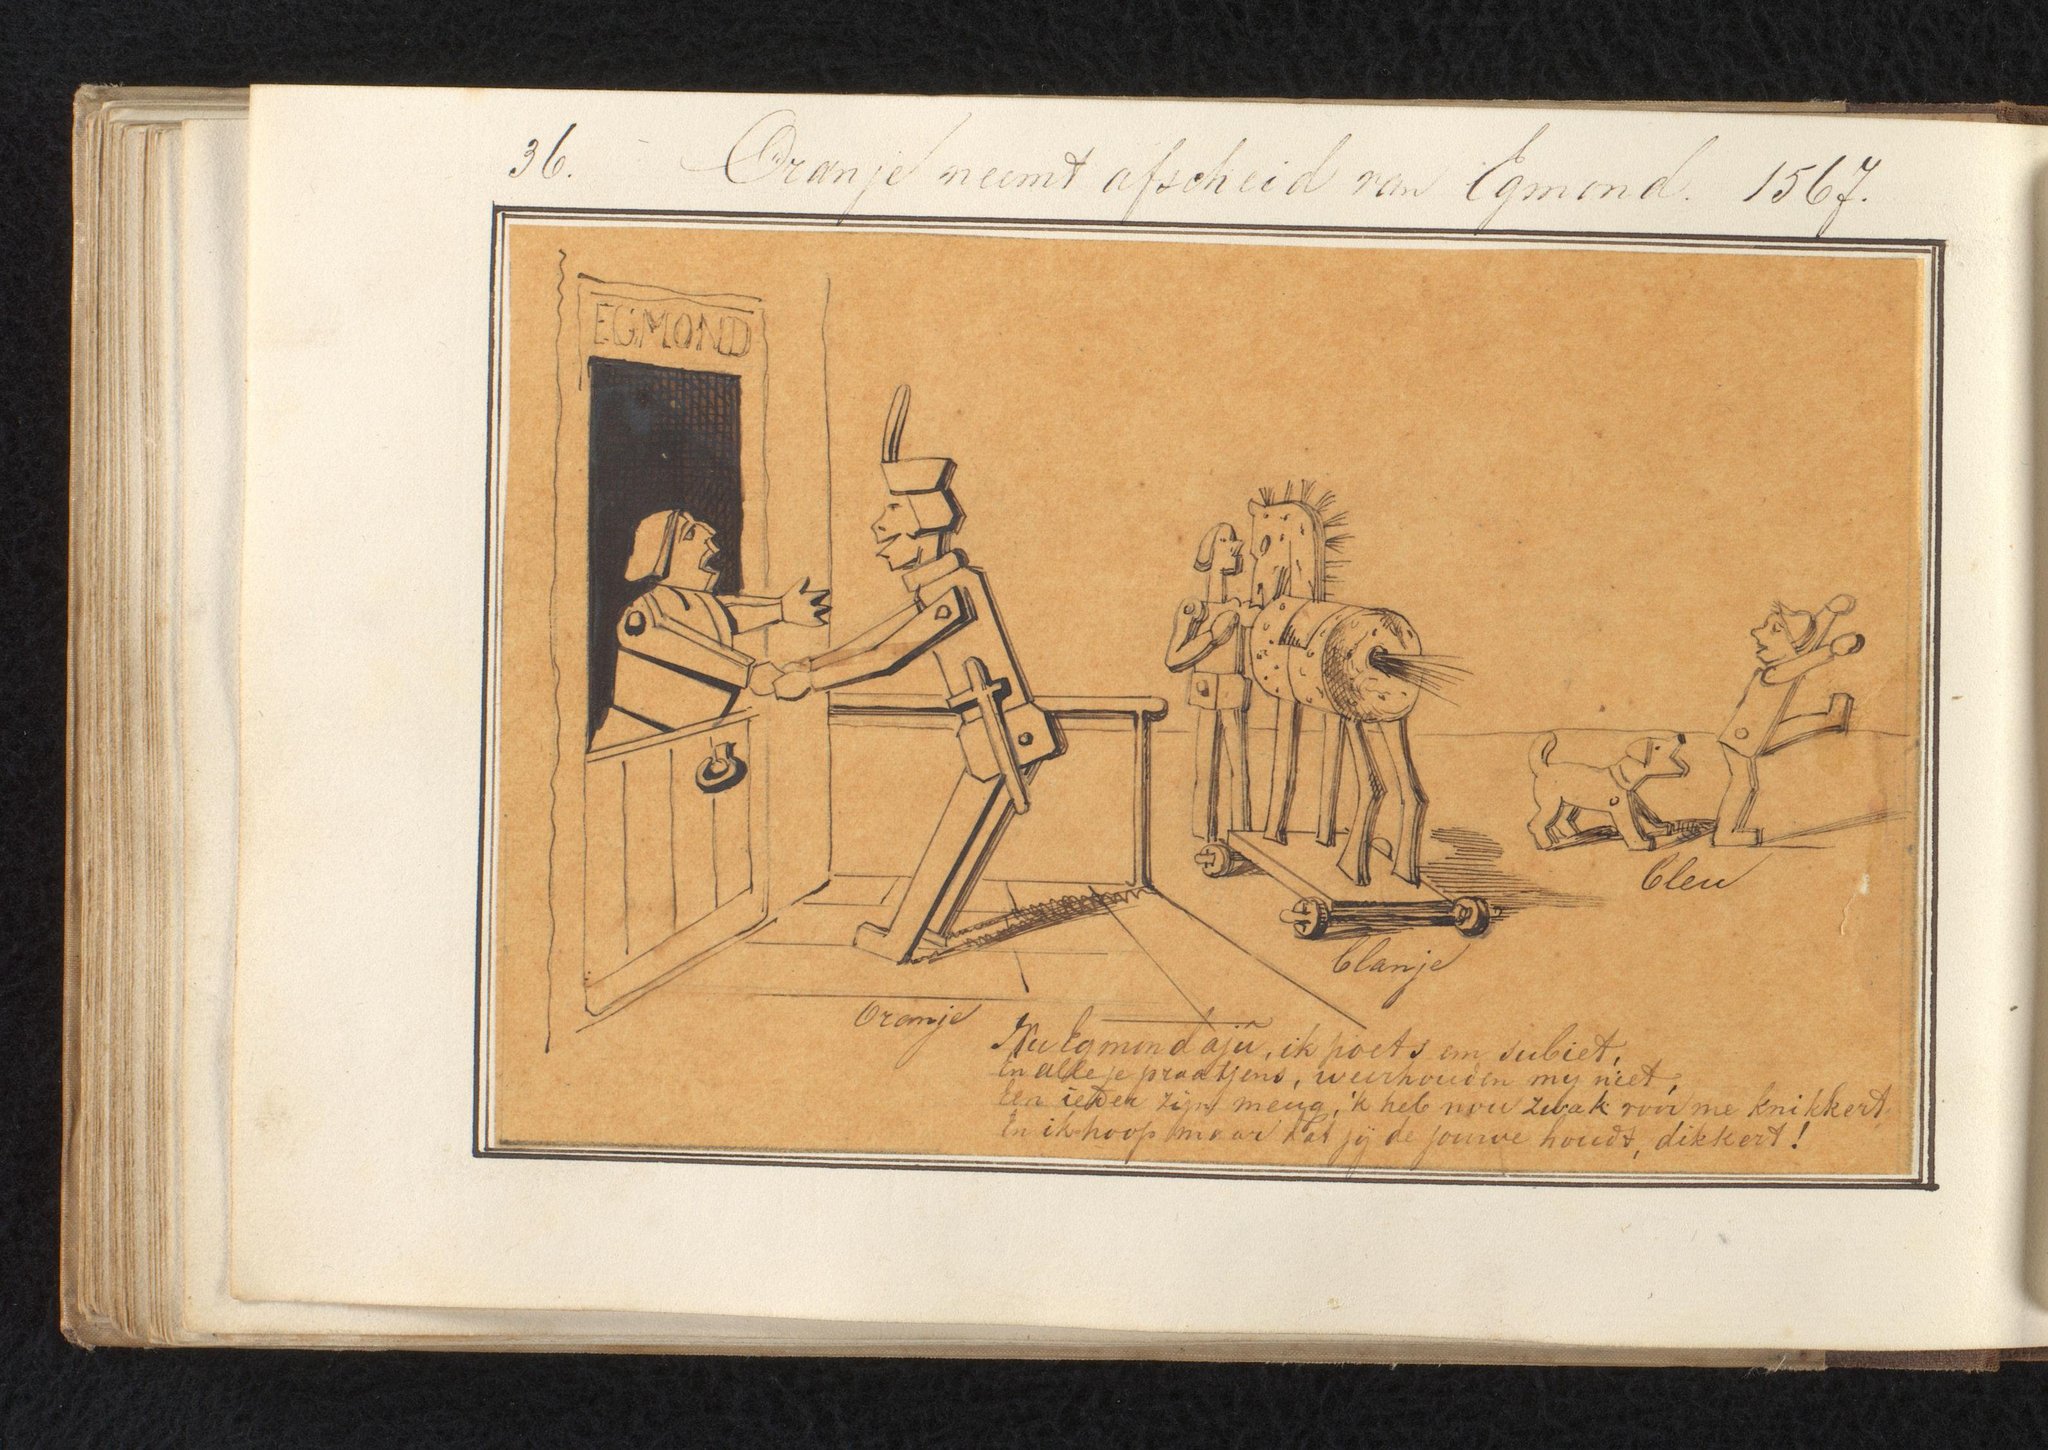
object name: album leaf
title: Willem van Oranje neemt afscheid van Lamoraal van Egmont en vertrekt naar Duitsland, 1567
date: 1853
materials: ink, pencil, paper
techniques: brush, pen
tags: delft, william i (prince of orange), brussels, earl, rocking-horse, political caricatures and satires, dog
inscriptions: inscription: ‘Oranje - blanje - bleu/ Nu Egmond aji dan, ik poets em subiet/ En alle je praatjens, weerhouden mij niet,/ Een ieder zijn meug, 'k heb nou zwak voor me knikkert/ En ik hoop maar dat jij de jouwe houdt, dikkert!’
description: Ontwerp voor: Lennep, Jacob van. Tafereelen uit de geschiedenis des vaderlands, tot nut van groot en klein. Amsterdam: M.H. Binger en Zonen, 1854.